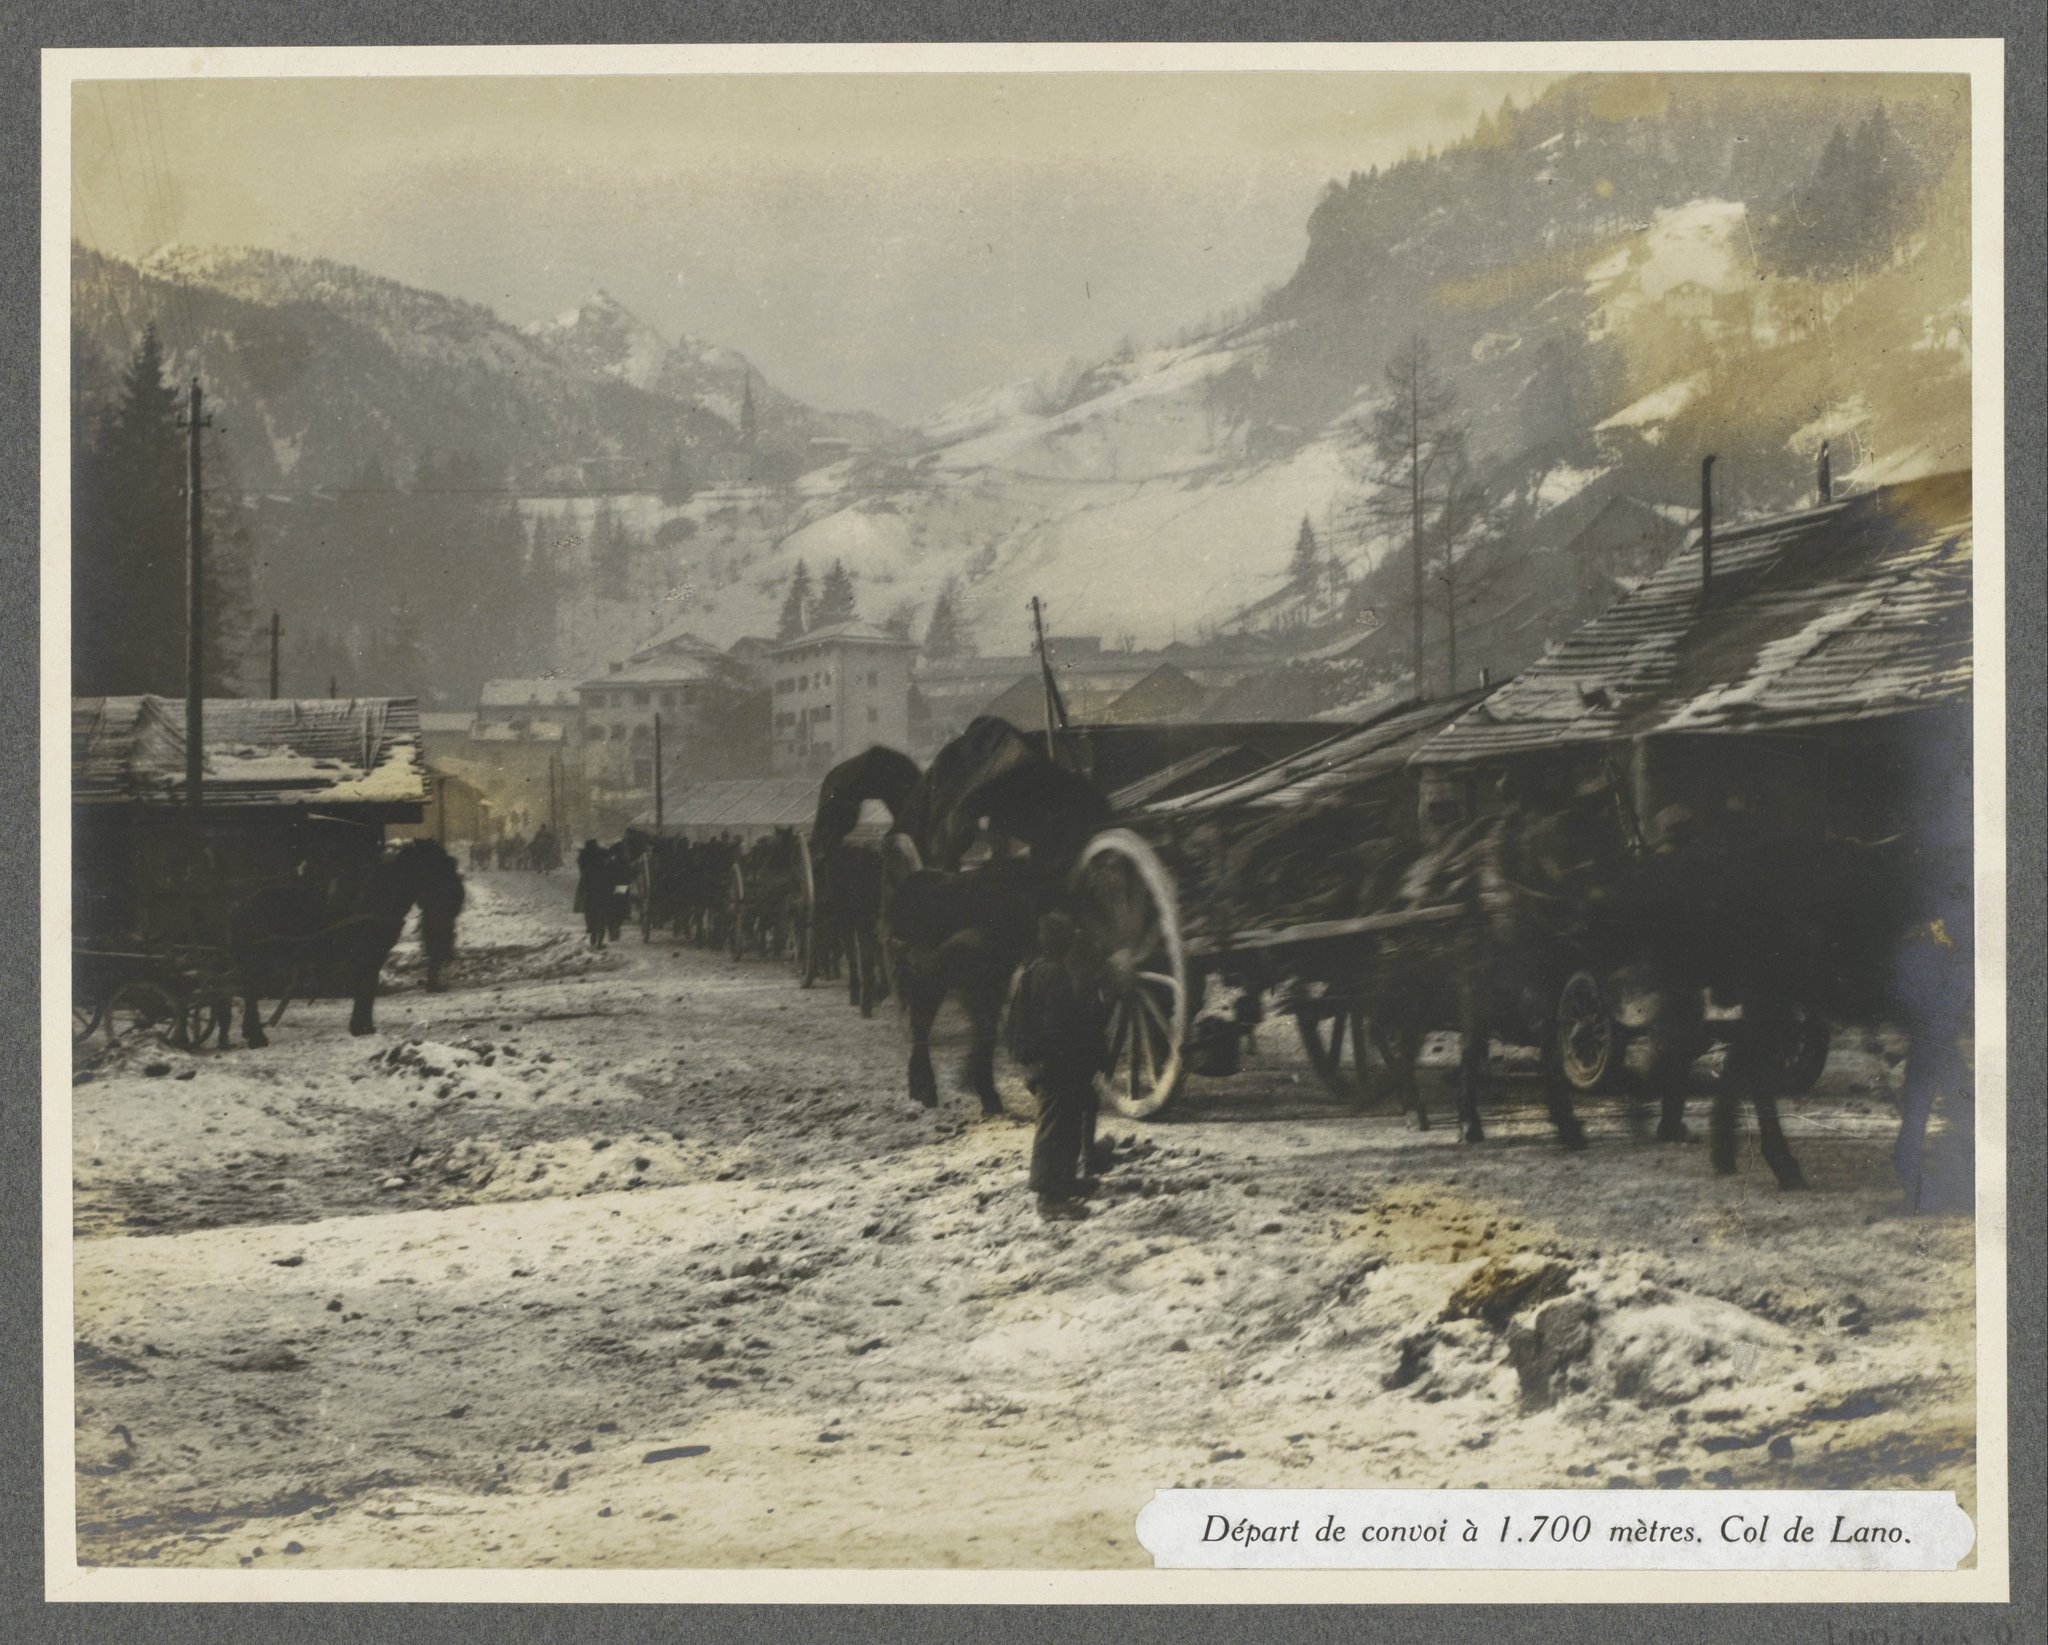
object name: photograph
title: Départ de convoi à 1.700 mètres. Col de Lano.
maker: henri de rothschild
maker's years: 1872-1947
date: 1916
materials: photographic support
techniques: gelatin silver print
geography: col di lana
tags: war (+ land forces), mountain-range, snow peaks, transport, train (military) (+ land forces)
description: Onderdeel van Fotoalbum Medische missie H. de Rothschild naar het Italiaanse front 1916.